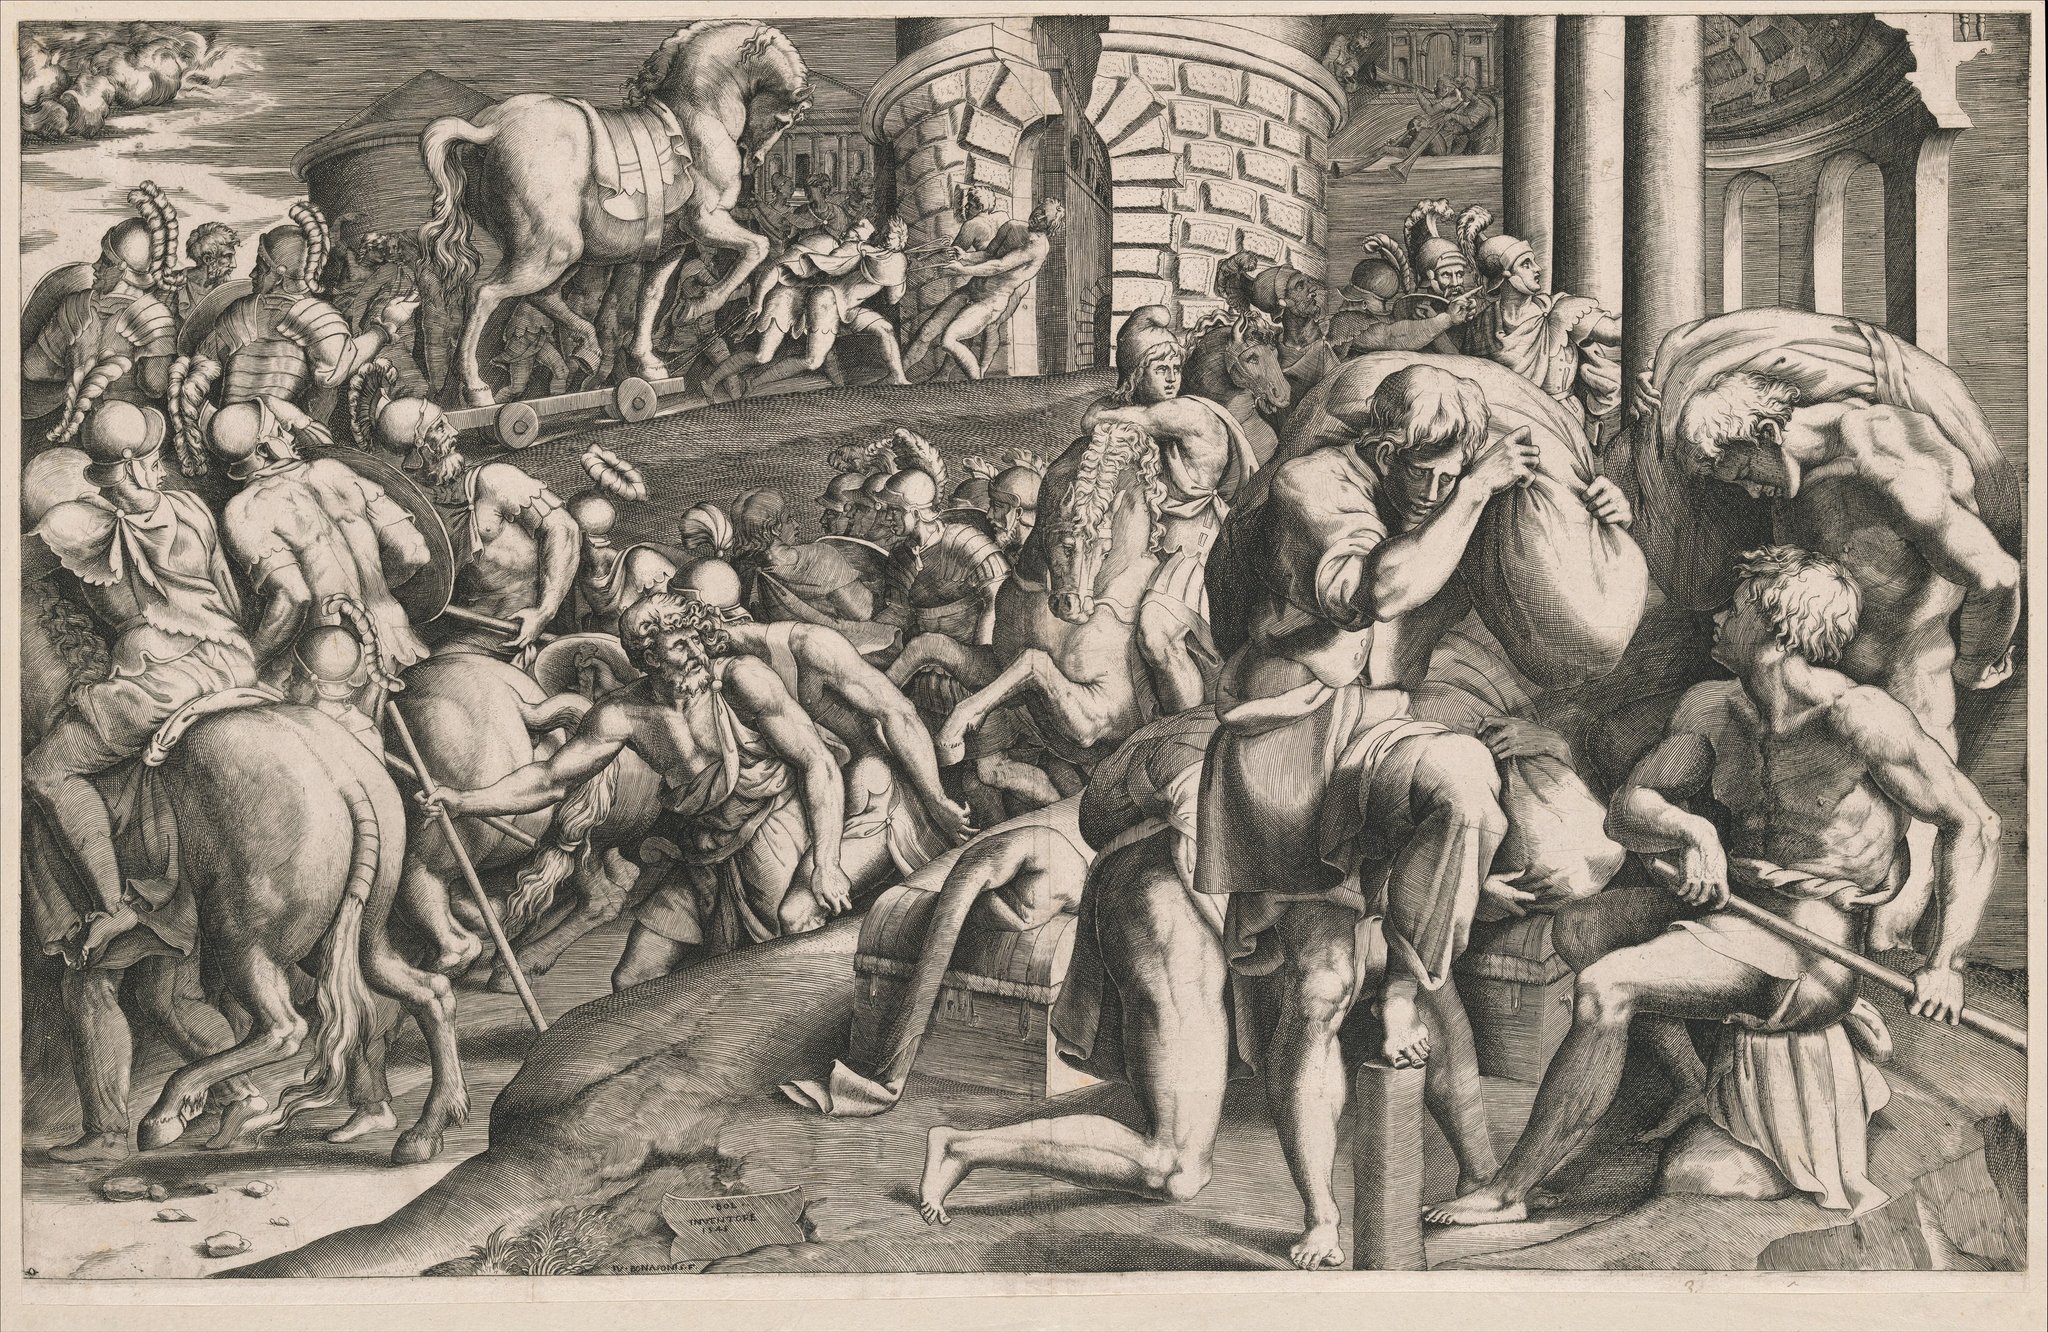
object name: print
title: The Trojans pulling the wooden horse into the city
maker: giulio bonasone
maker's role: artist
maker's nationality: italian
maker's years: 1510-1576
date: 1545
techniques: engraving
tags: soldiers,trojan war,men,horses